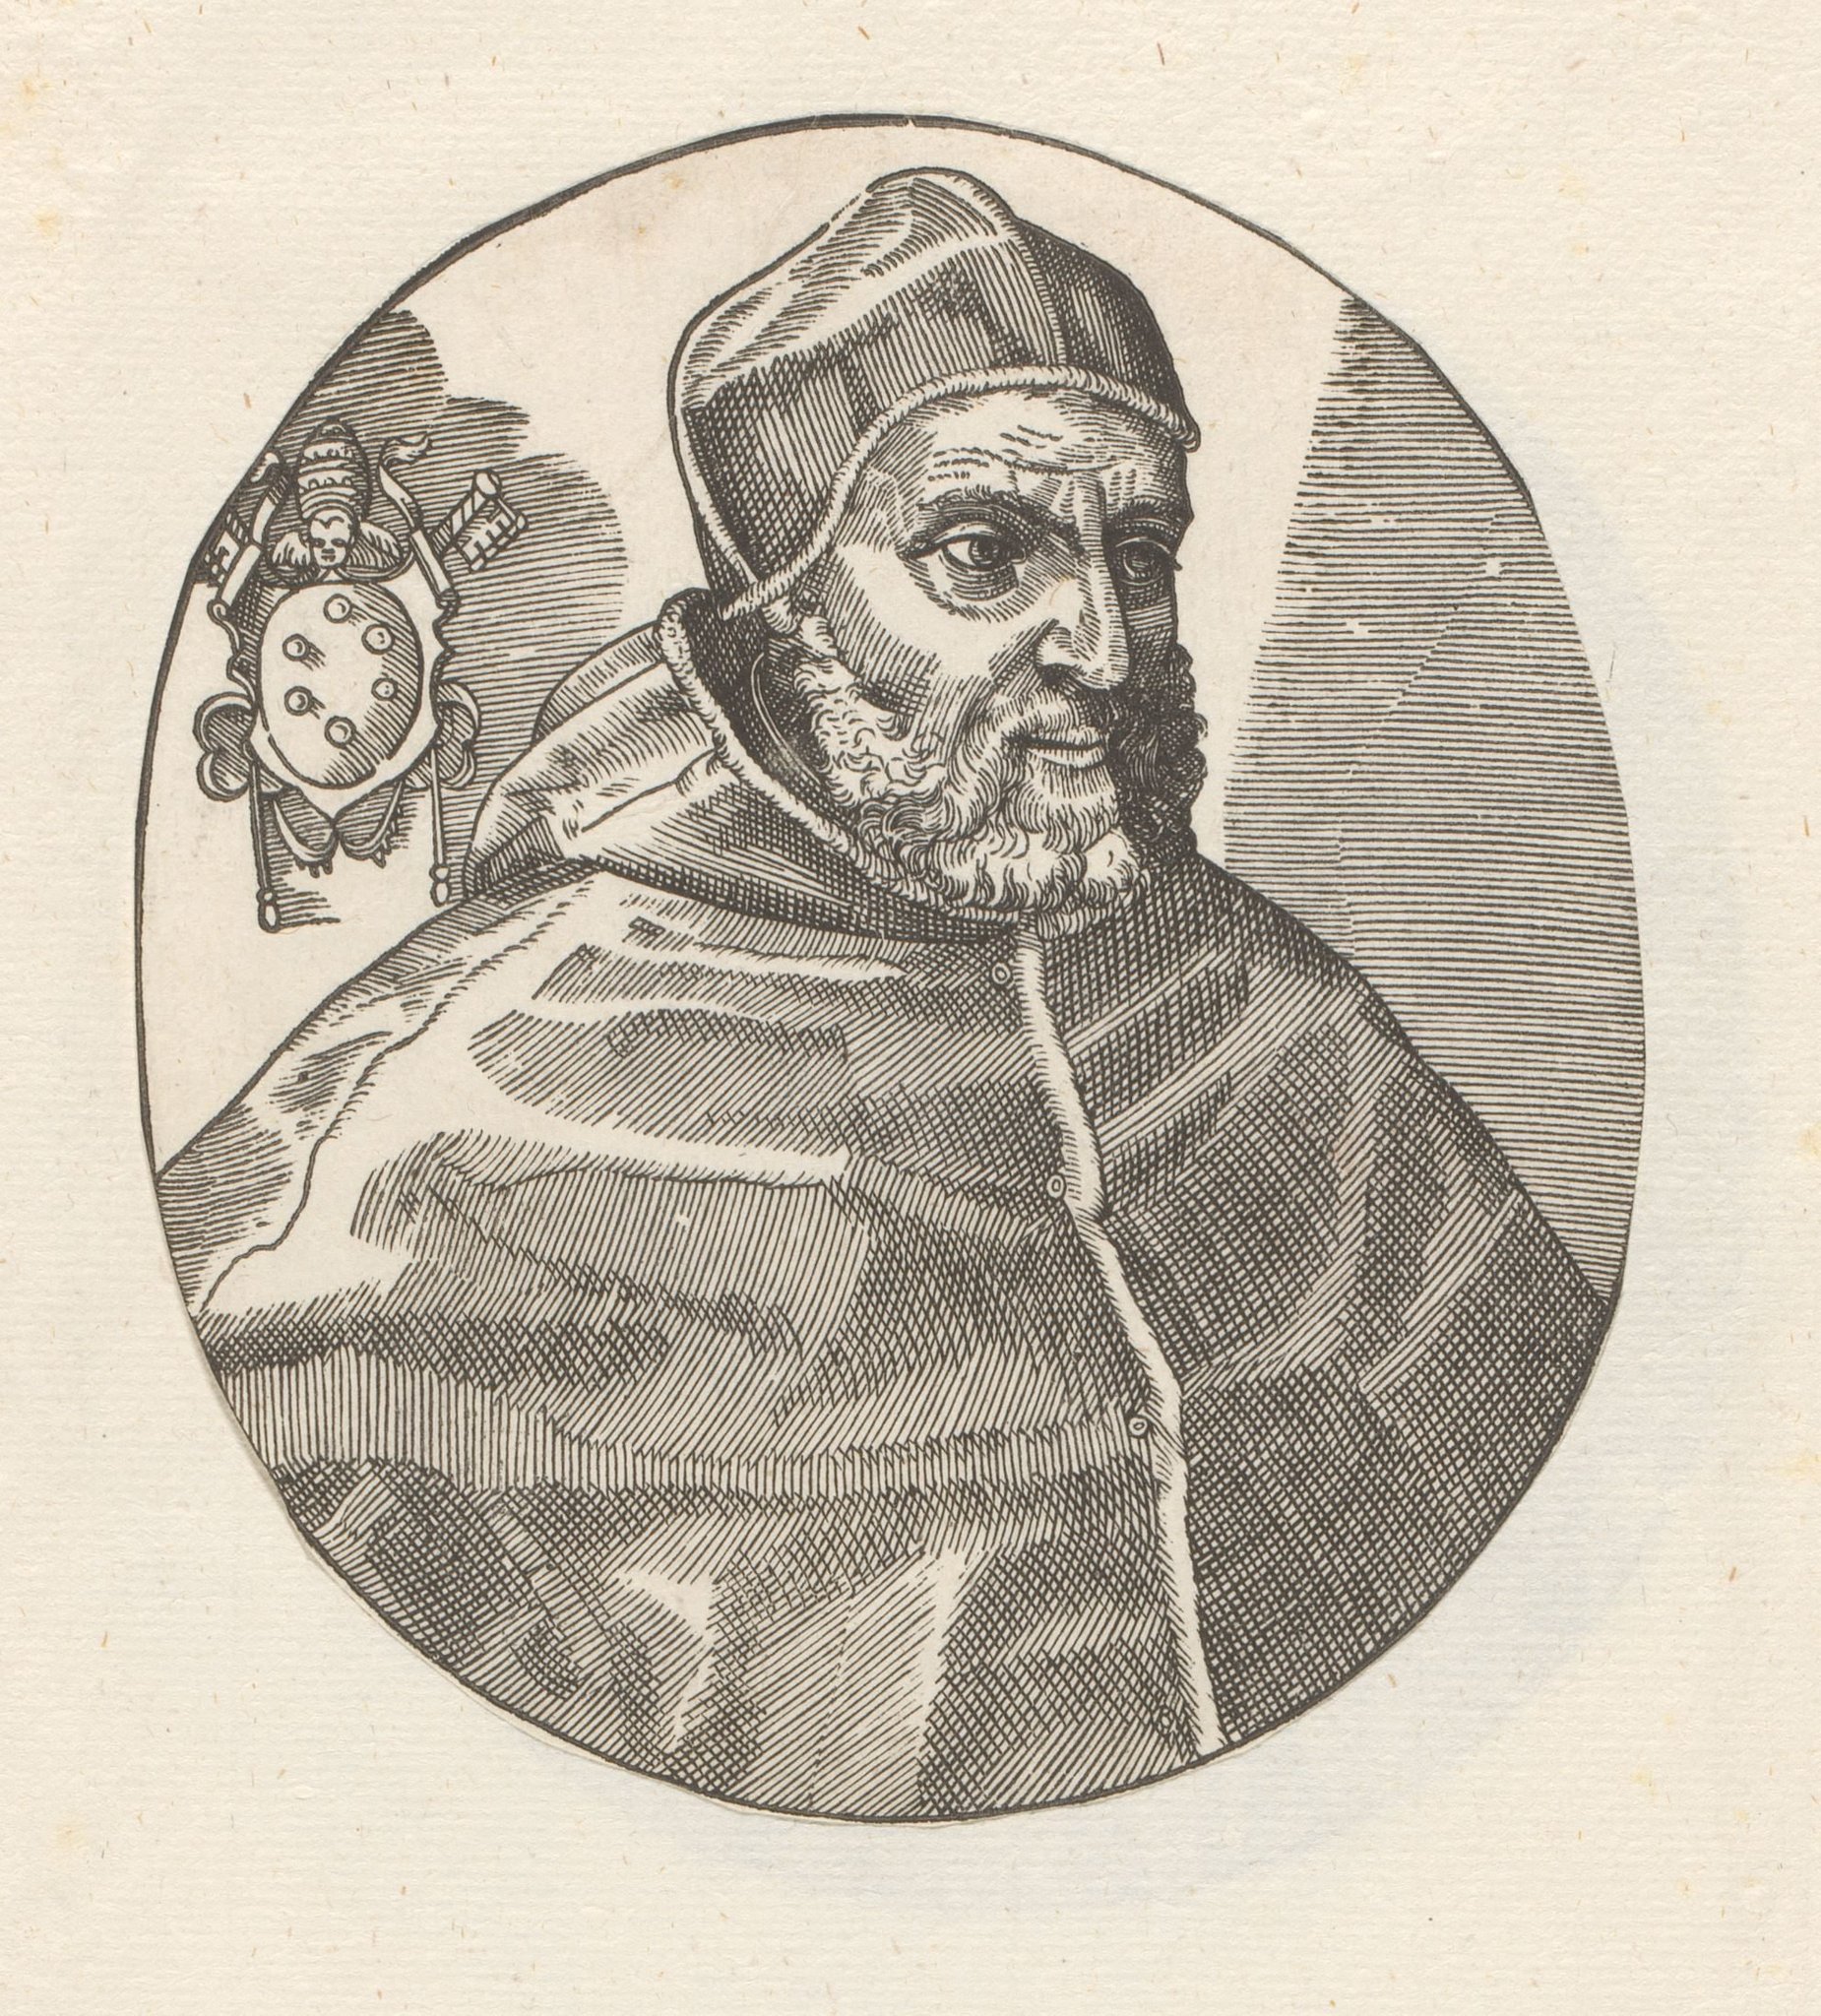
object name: print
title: Portret van paus Pius IV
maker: Anonymous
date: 1549-1573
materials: paper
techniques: woodcut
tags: pius iv, historical persons, pope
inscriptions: collector's mark: Lugt 240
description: Prent gebruikt in: Panvinio, Onofrio. Accuratae Effigies Pontificum (...). Straatsburg: Bernhard Jobin, 1573.